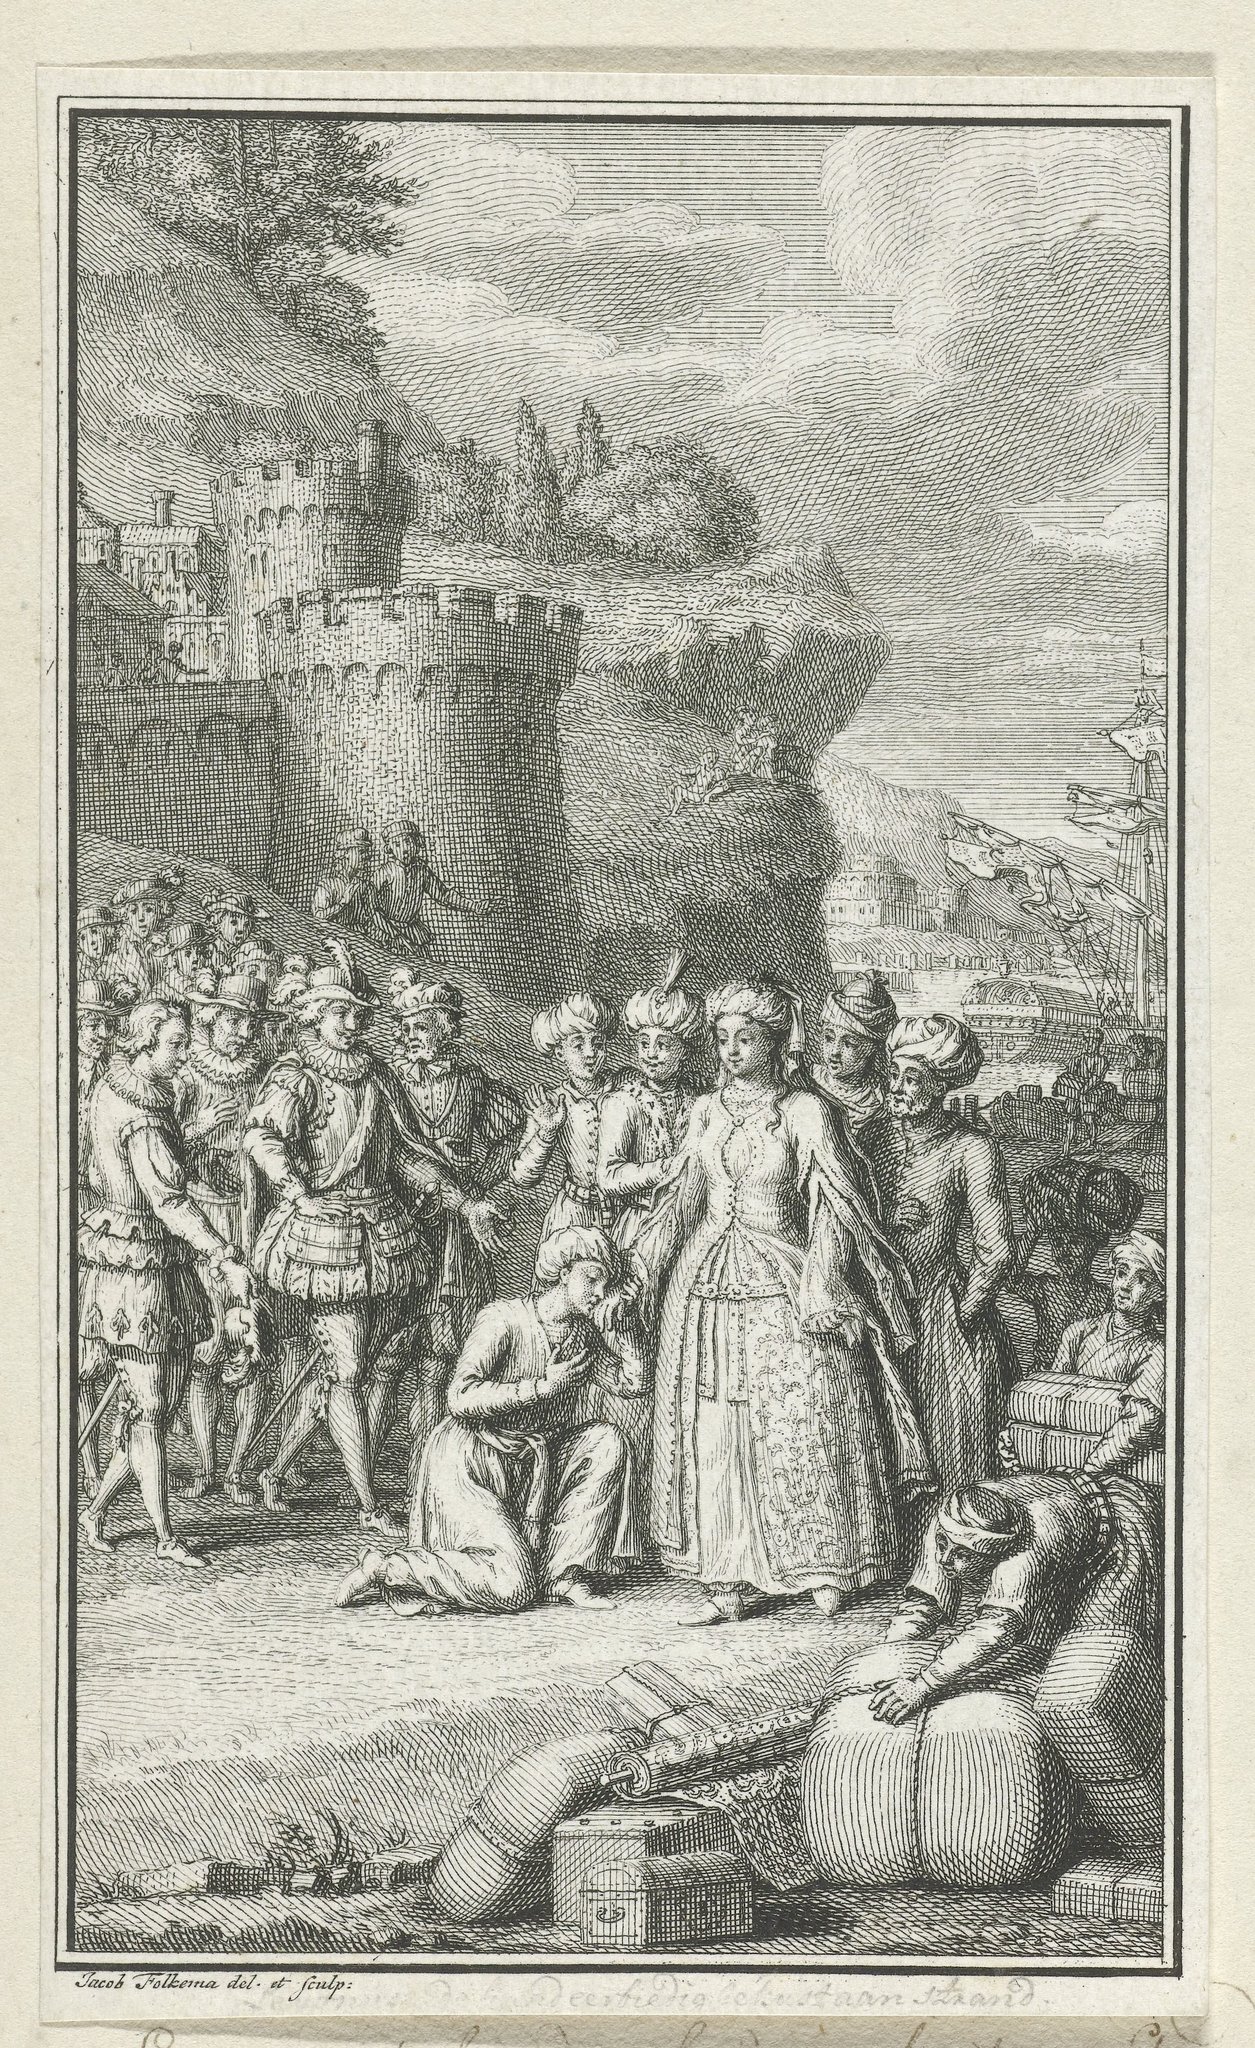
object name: print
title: Oosterse vrouw verwelkomd met een handkus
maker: jacob folkema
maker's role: draughtsman, print maker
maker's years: 1692-1767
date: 1702-1767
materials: paper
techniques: etching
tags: harbour, head-gear: turban, landscape with tower or castle, kissing the hand (lovers)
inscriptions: inscription: ‘Levonuse de hand eerbiedig gekust aan strand’, collector's mark: Lugt 2228, inscription: ‘Levonuse de hand eerbiedig gekust aan strand’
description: Bij een haven wordt een vrouw in Oosterse kleding verwelkomd door een groep Oosterlingen. Een van hen geeft de vrouw een handkus. Links kijken figuren in rijke Westerse kledij toe. Op de achtergrond zicht op het water en een burcht.